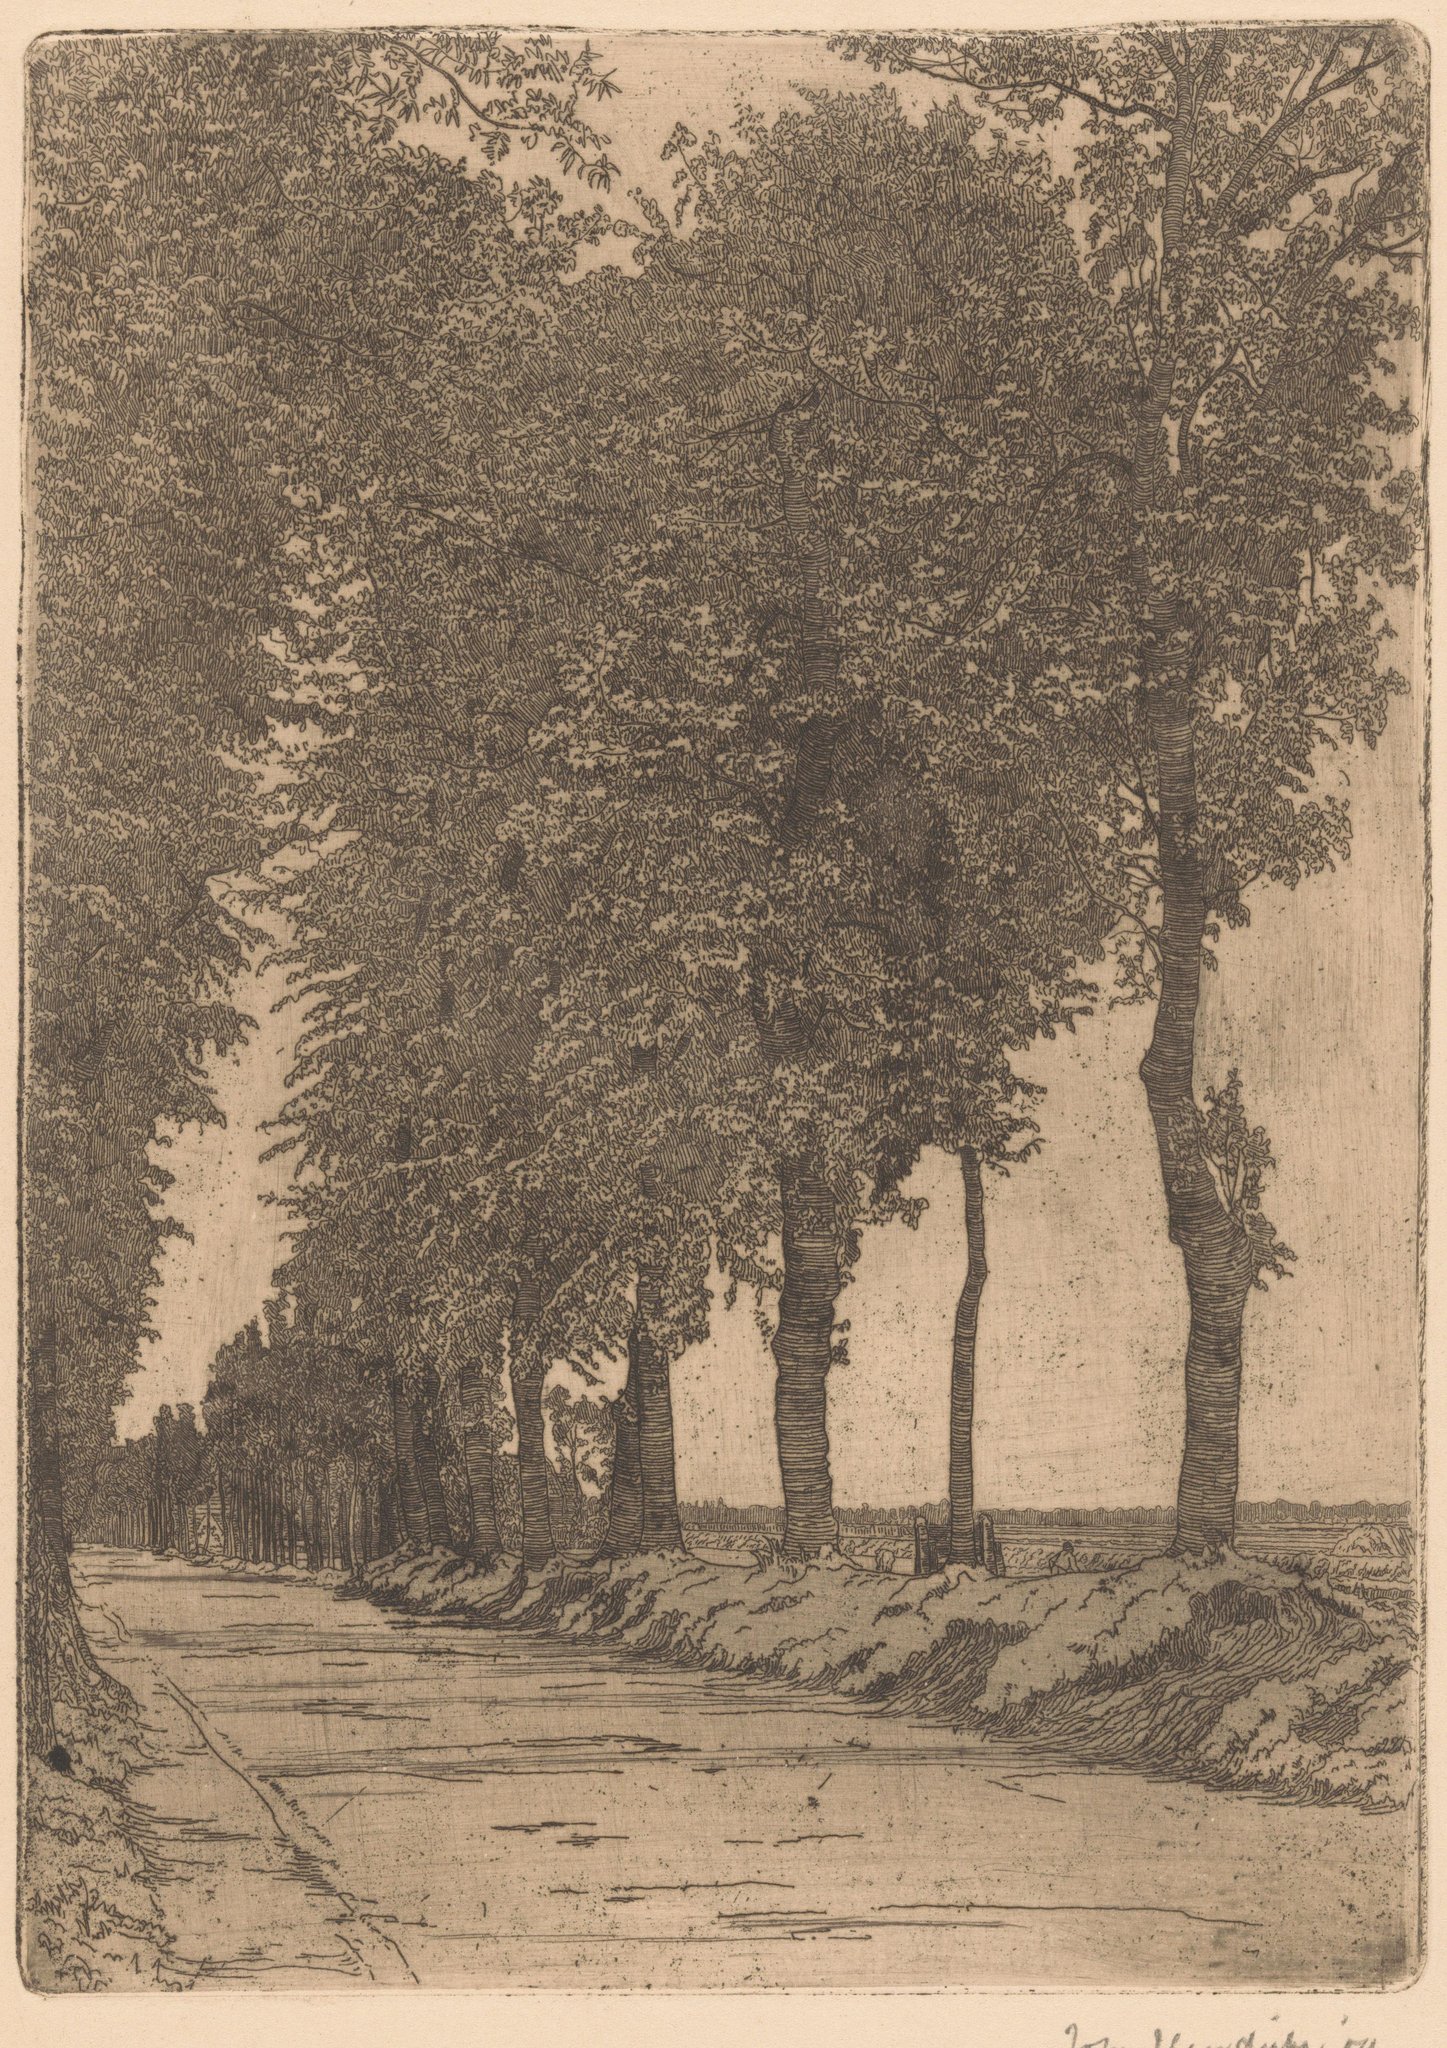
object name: print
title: De Amstelveensche weg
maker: johannes henrichs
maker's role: print maker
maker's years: 1882-1954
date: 1909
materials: paper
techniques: etching, intaglio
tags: trees, street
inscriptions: collector's mark: Lugt 2228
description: Bomen langs de Amstelveenseweg tussen Amsterdam en Amstelveen.